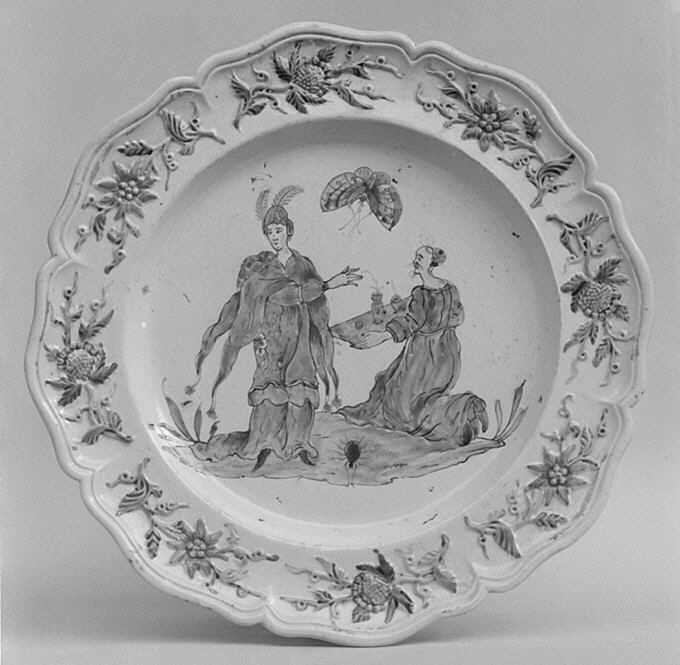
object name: plate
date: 1760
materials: stoneware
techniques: salt glaze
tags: men,flowers